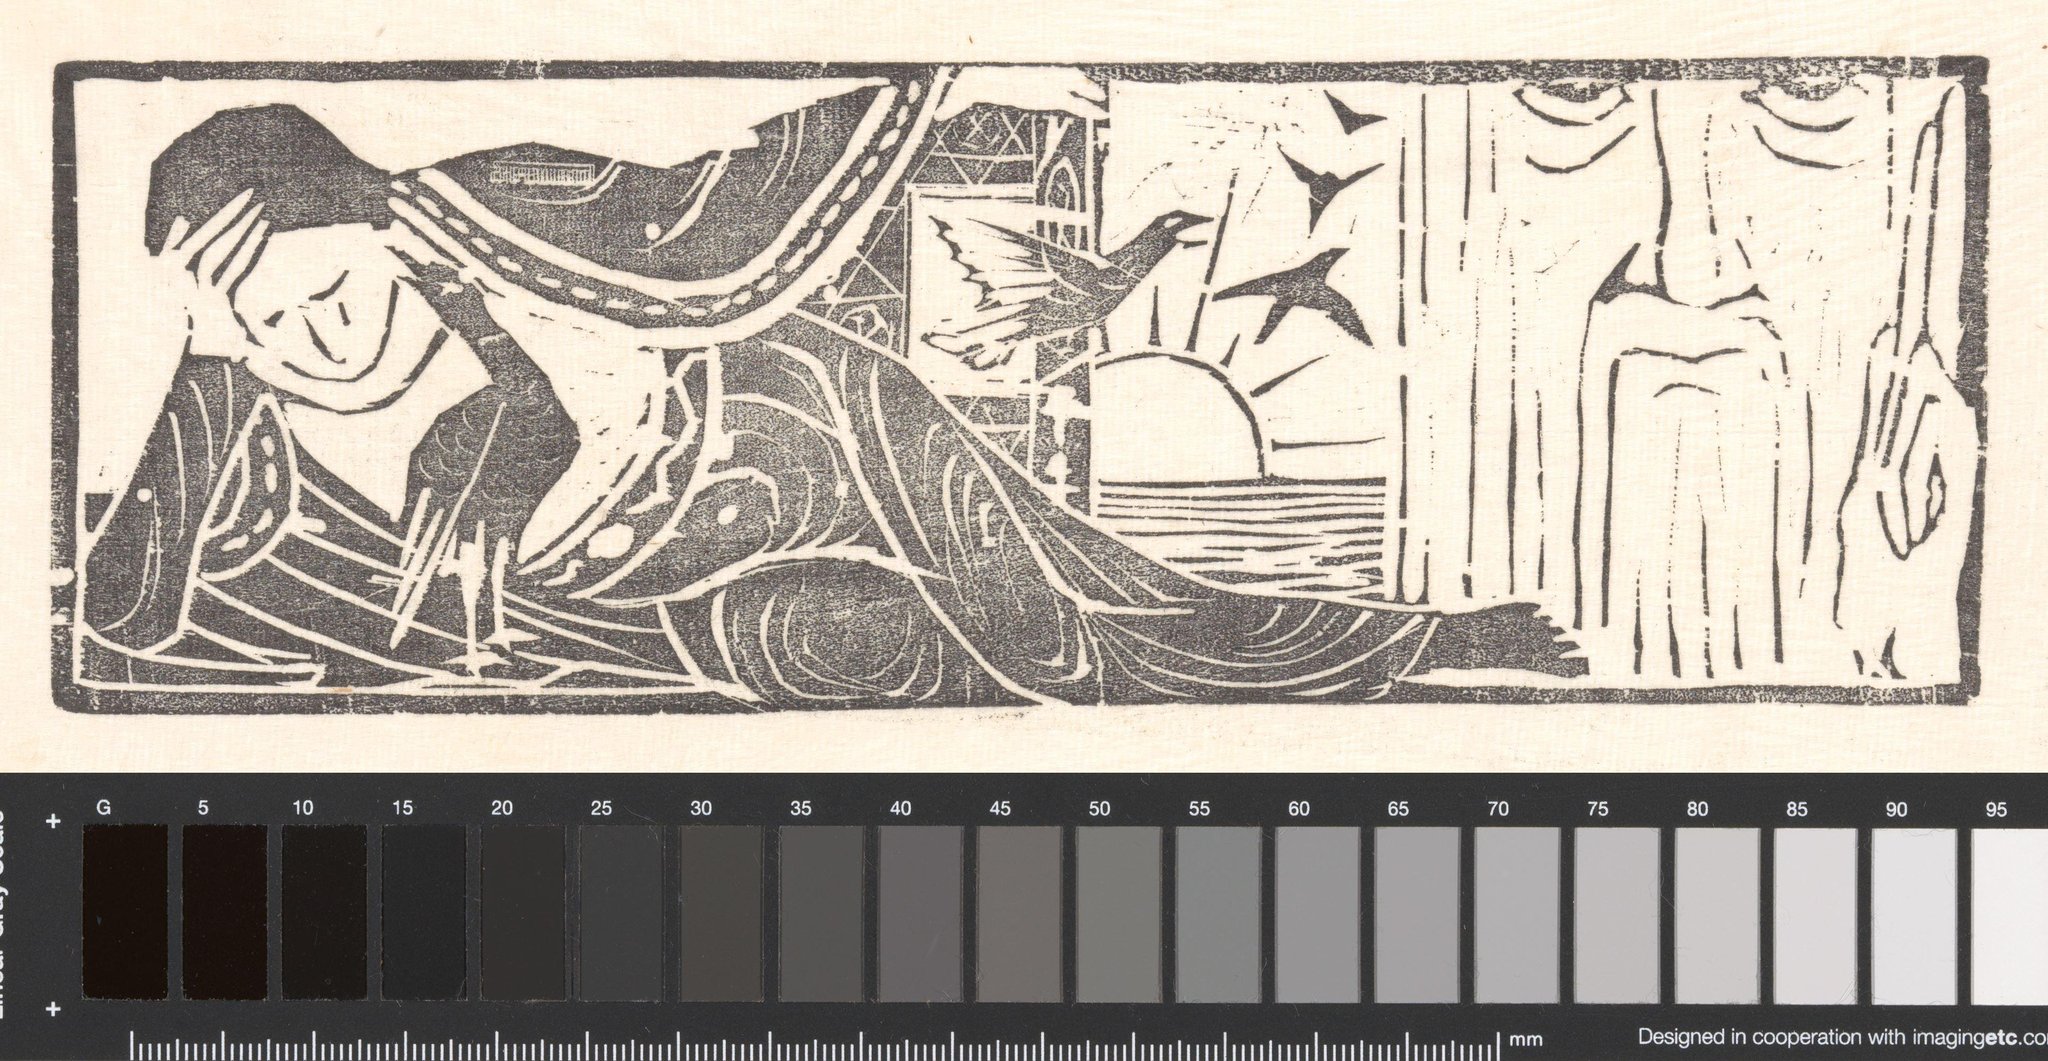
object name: illustration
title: Liggende figuur met vogels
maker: mathieu lauweriks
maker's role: designer, draughtsman, print maker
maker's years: 1864-1932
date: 1894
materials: paper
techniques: woodcut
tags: birds, index finger and middle finger raised, closed, lying on one side, with uplifted upper part of the body and leaning on the arm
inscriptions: collector's mark: Lugt 2228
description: Een figuur ligt op de zij, steunend op zijn rechterarm. Voor hem zit een vogel; achter hem vliegen vier vogels weg richting de zon. Rechts het gezicht van een man die twee vingers opsteekt.